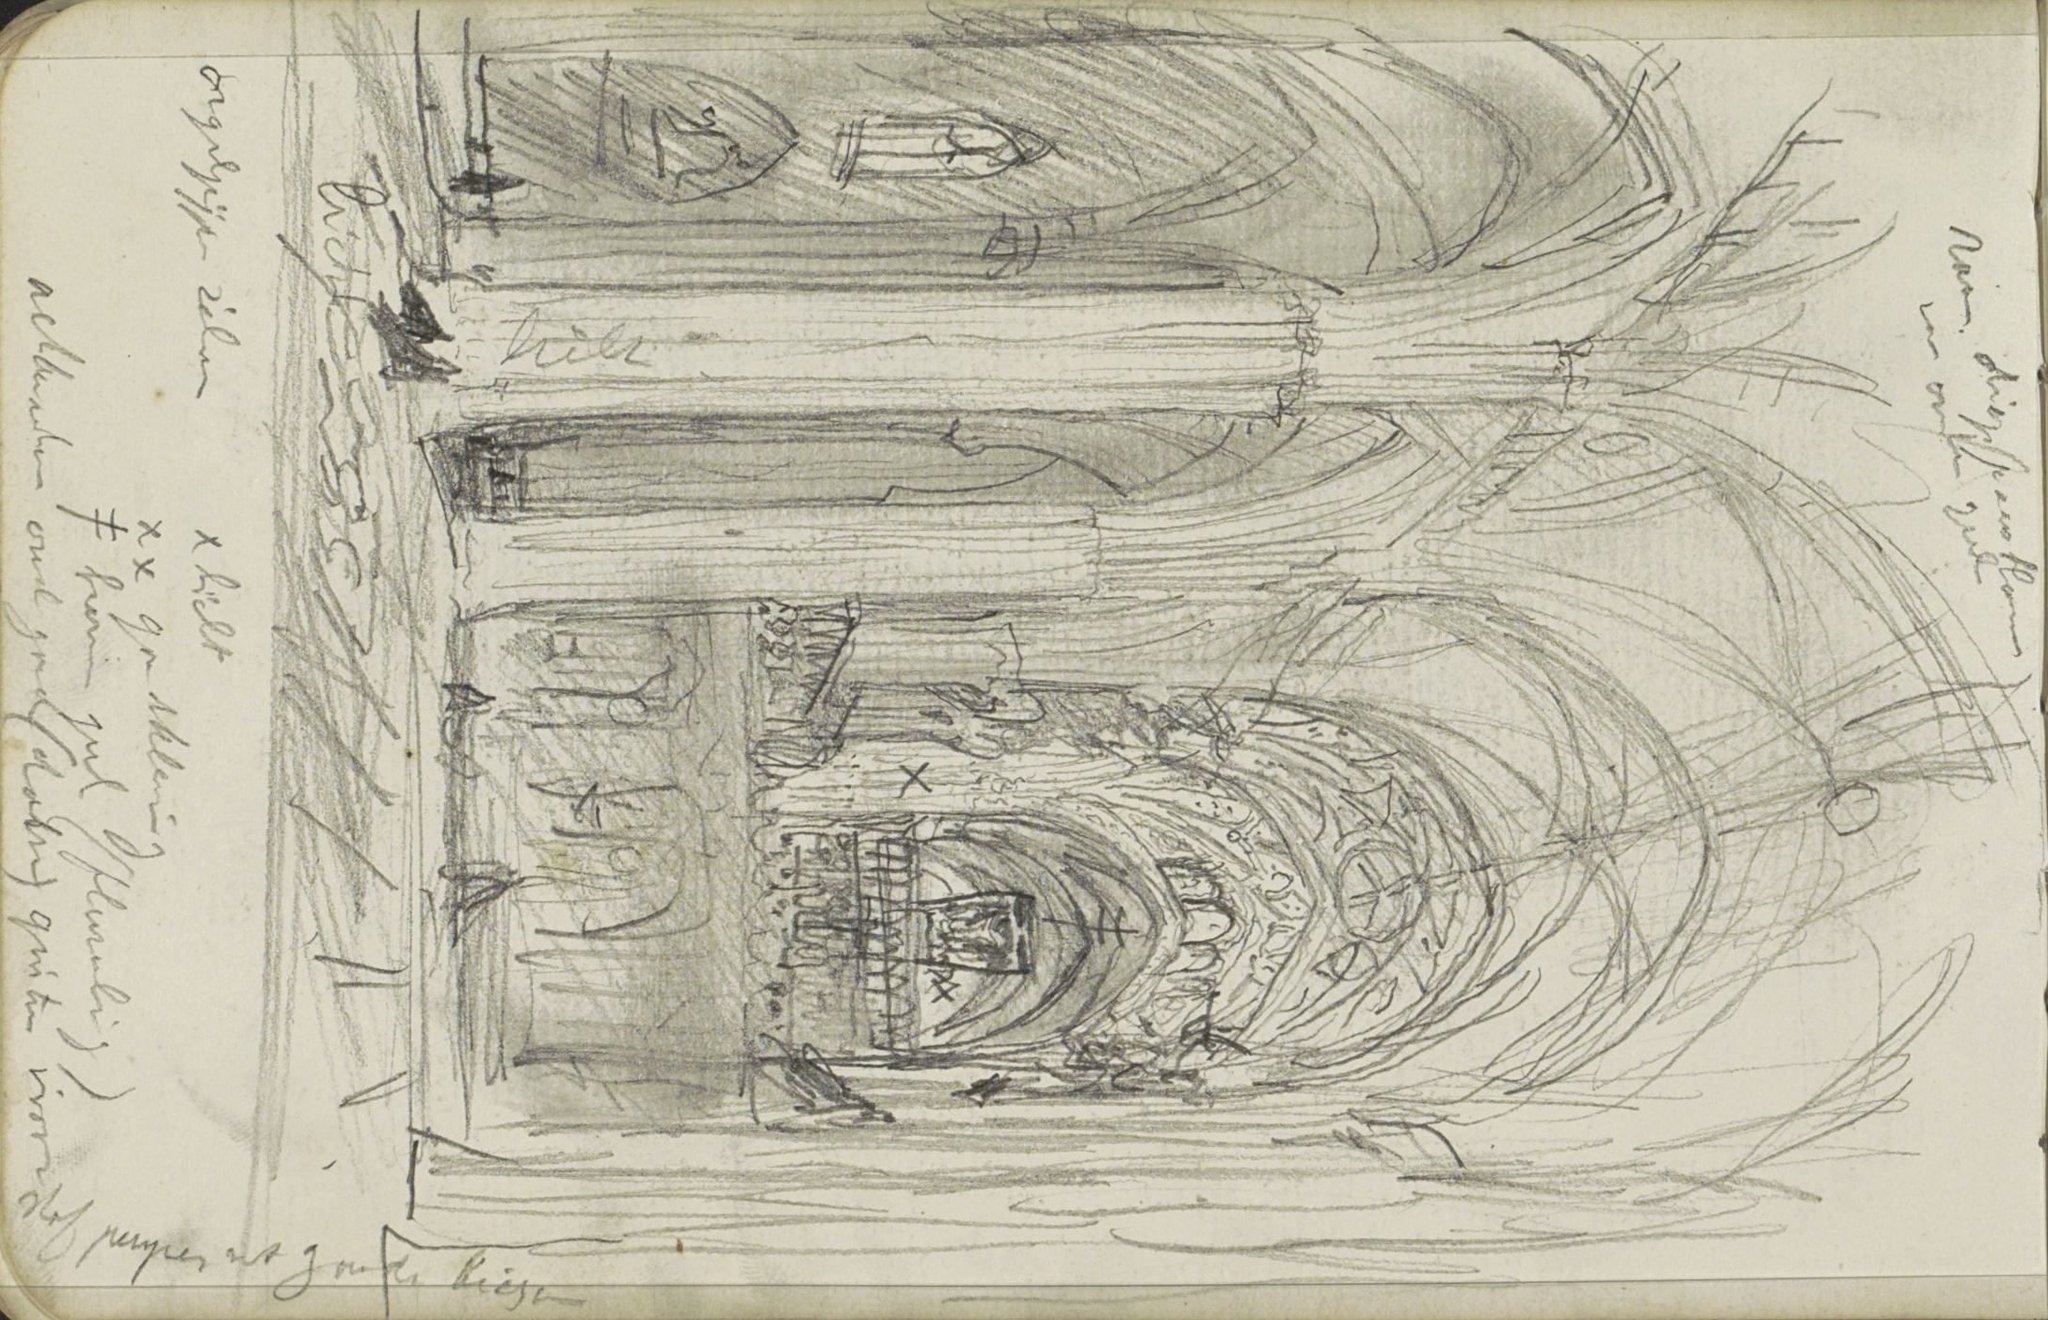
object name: sketchbook leaf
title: Interieur van de kathedraal van Sevilla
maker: marius bauer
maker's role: draughtsman, print maker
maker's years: 1867-1932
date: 1902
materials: paper, pencil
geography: sevilla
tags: interior of church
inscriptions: kleurnotitie, handgeschreven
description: Pagina 32 uit een schetsboek met 30 bladen.